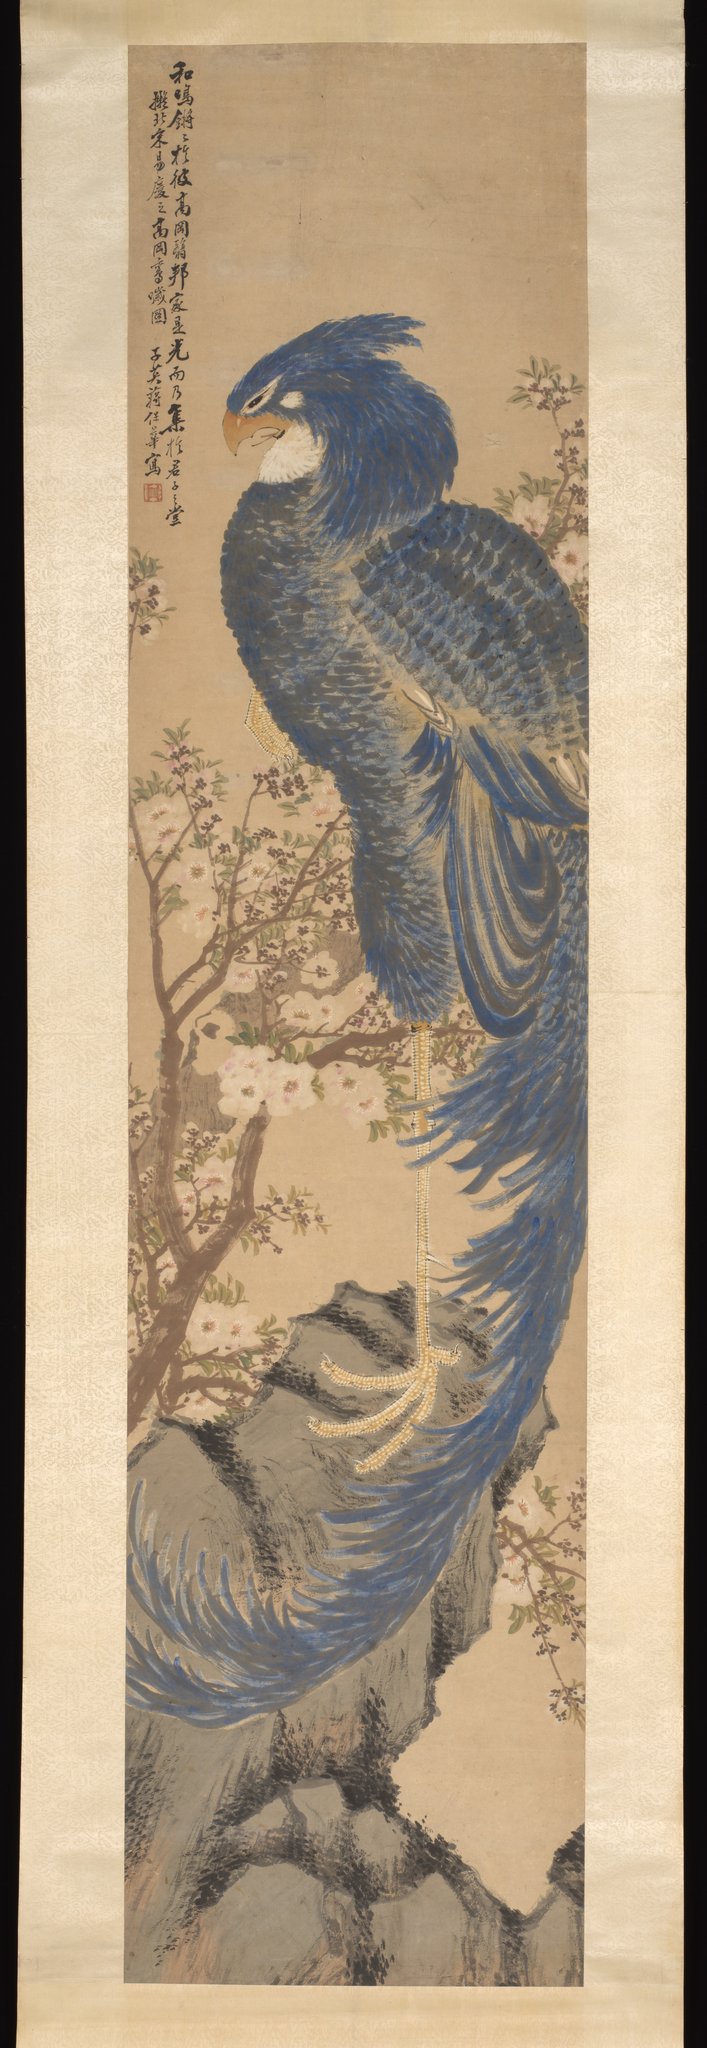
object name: hanging scroll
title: Blue Phoenix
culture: chinese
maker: jiang baohua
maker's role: artist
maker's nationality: chinese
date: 1867-1933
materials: ink, paper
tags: phoenix